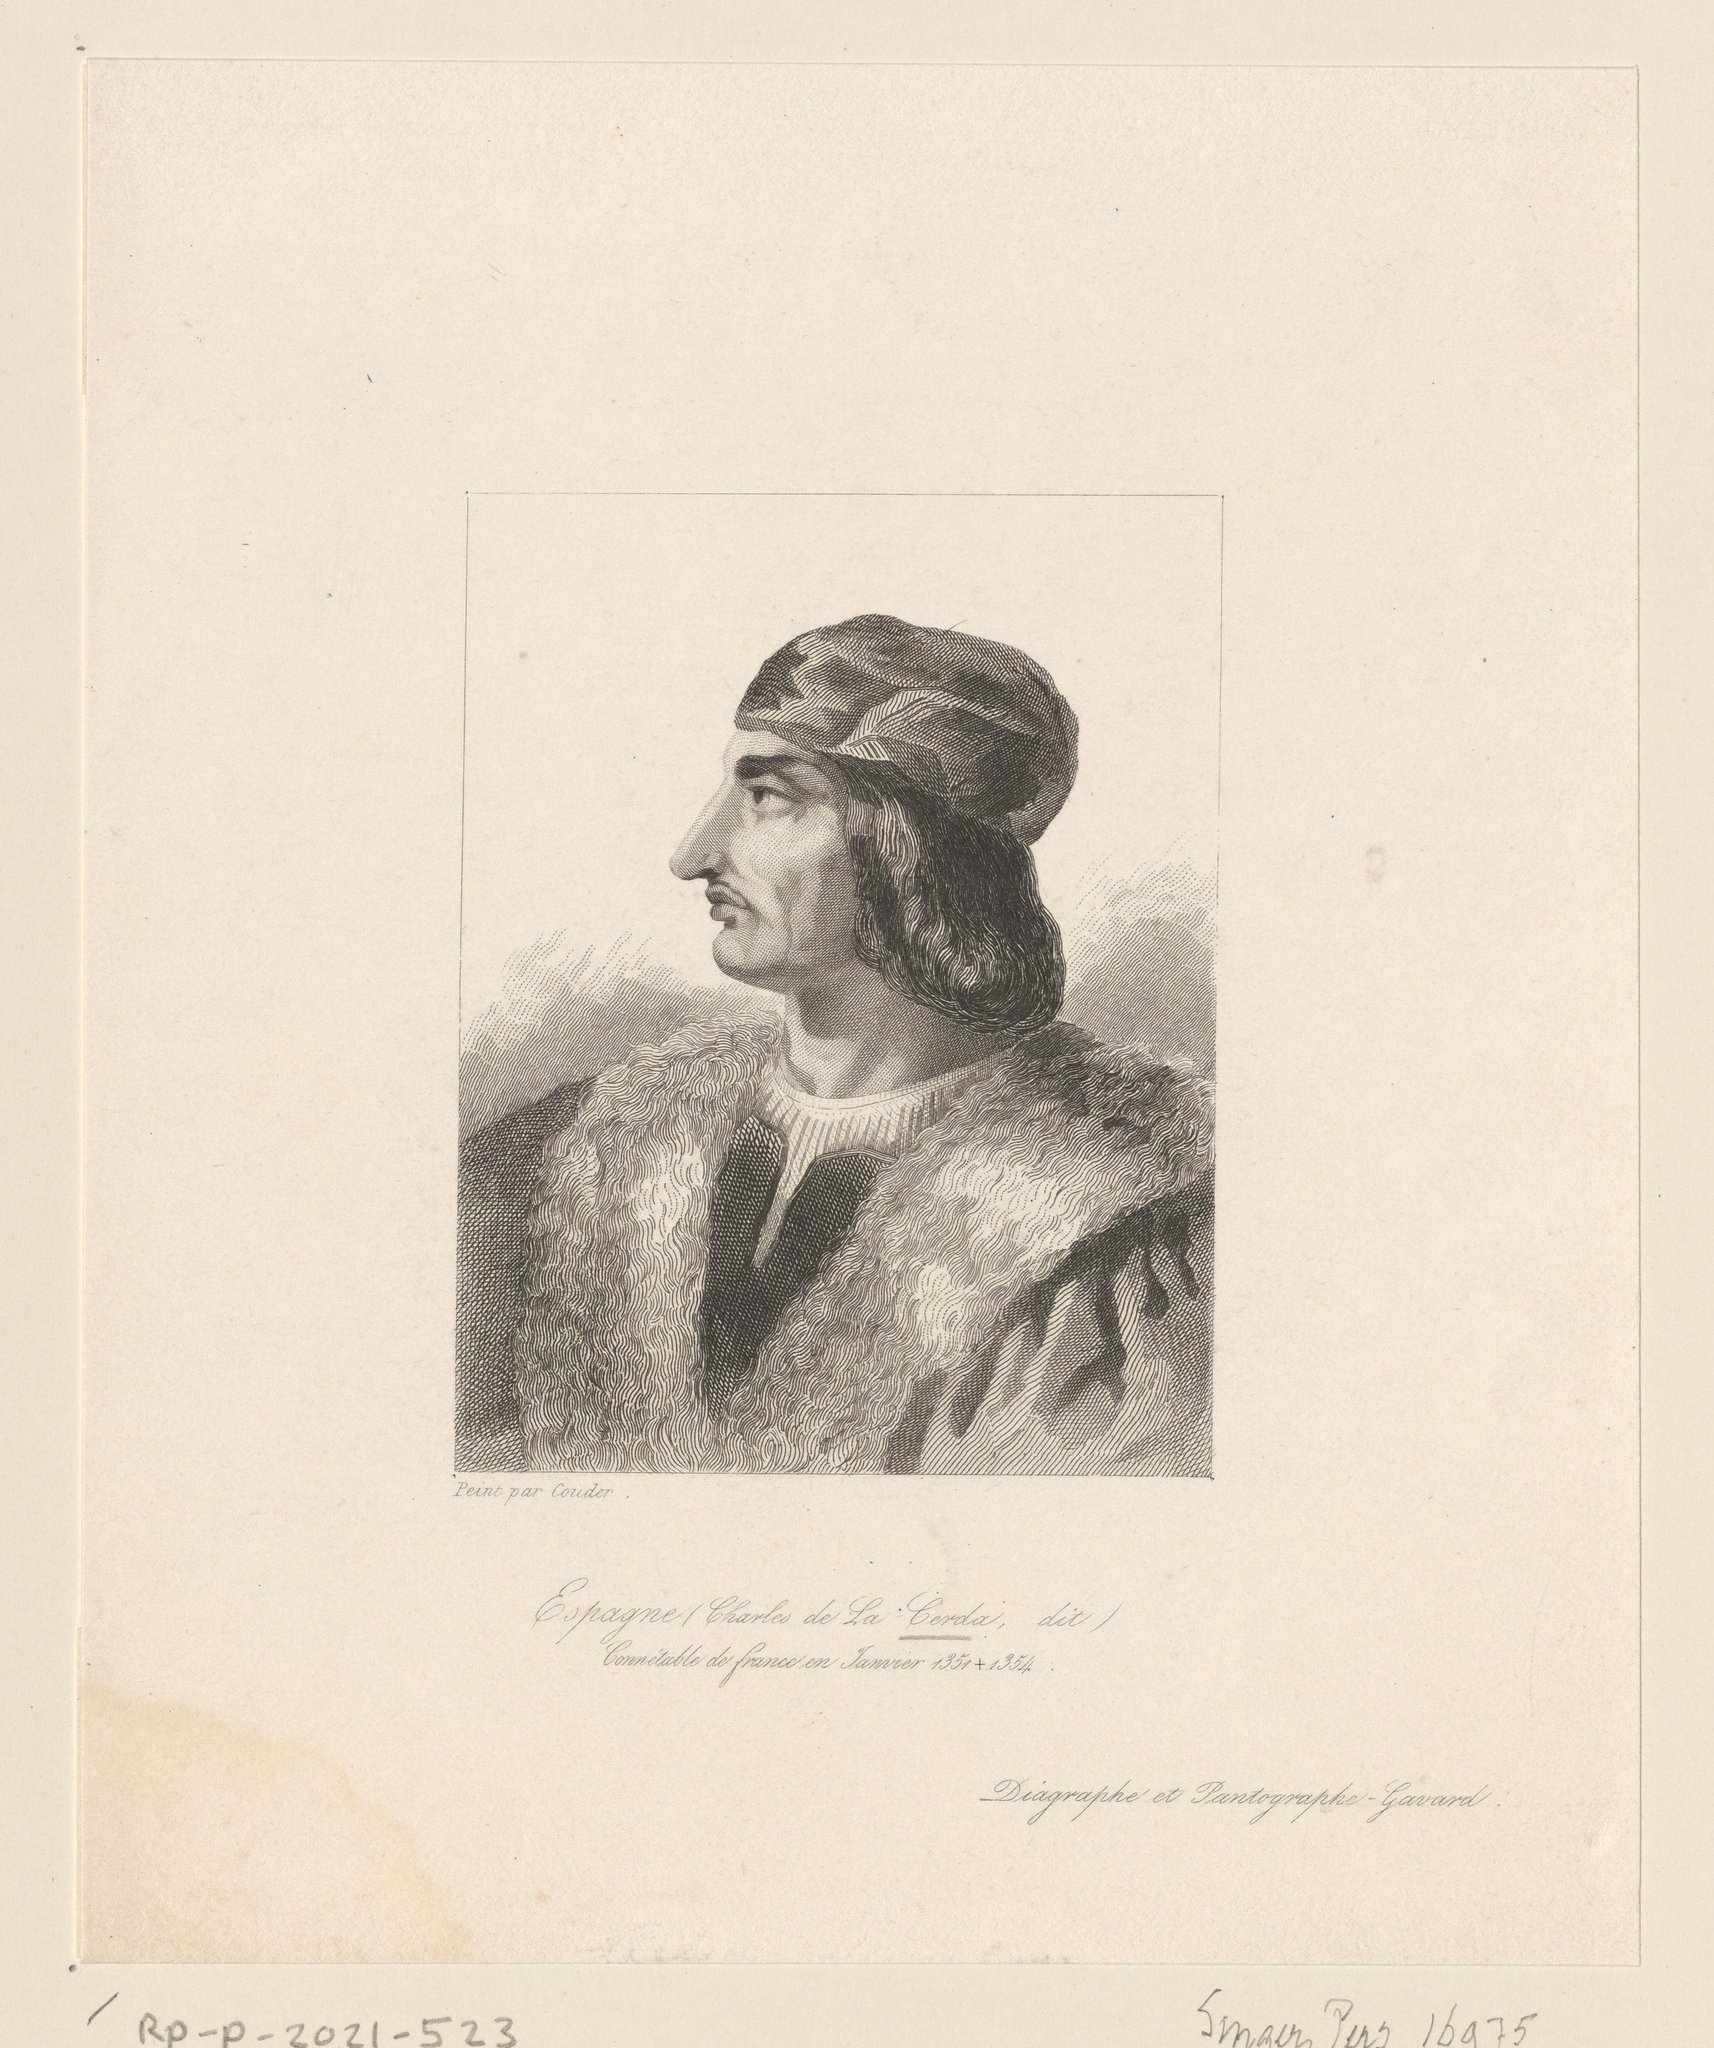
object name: print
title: Portret van Charles de La Cerda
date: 1846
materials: paper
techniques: etching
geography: france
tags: earl, historical persons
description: De prent is mogelijk gemaakt voor: Gavard, Charles. Galeries historiques du palais de Versailles. Parijs: Imprimerie Royale, 1846, dl. 8.